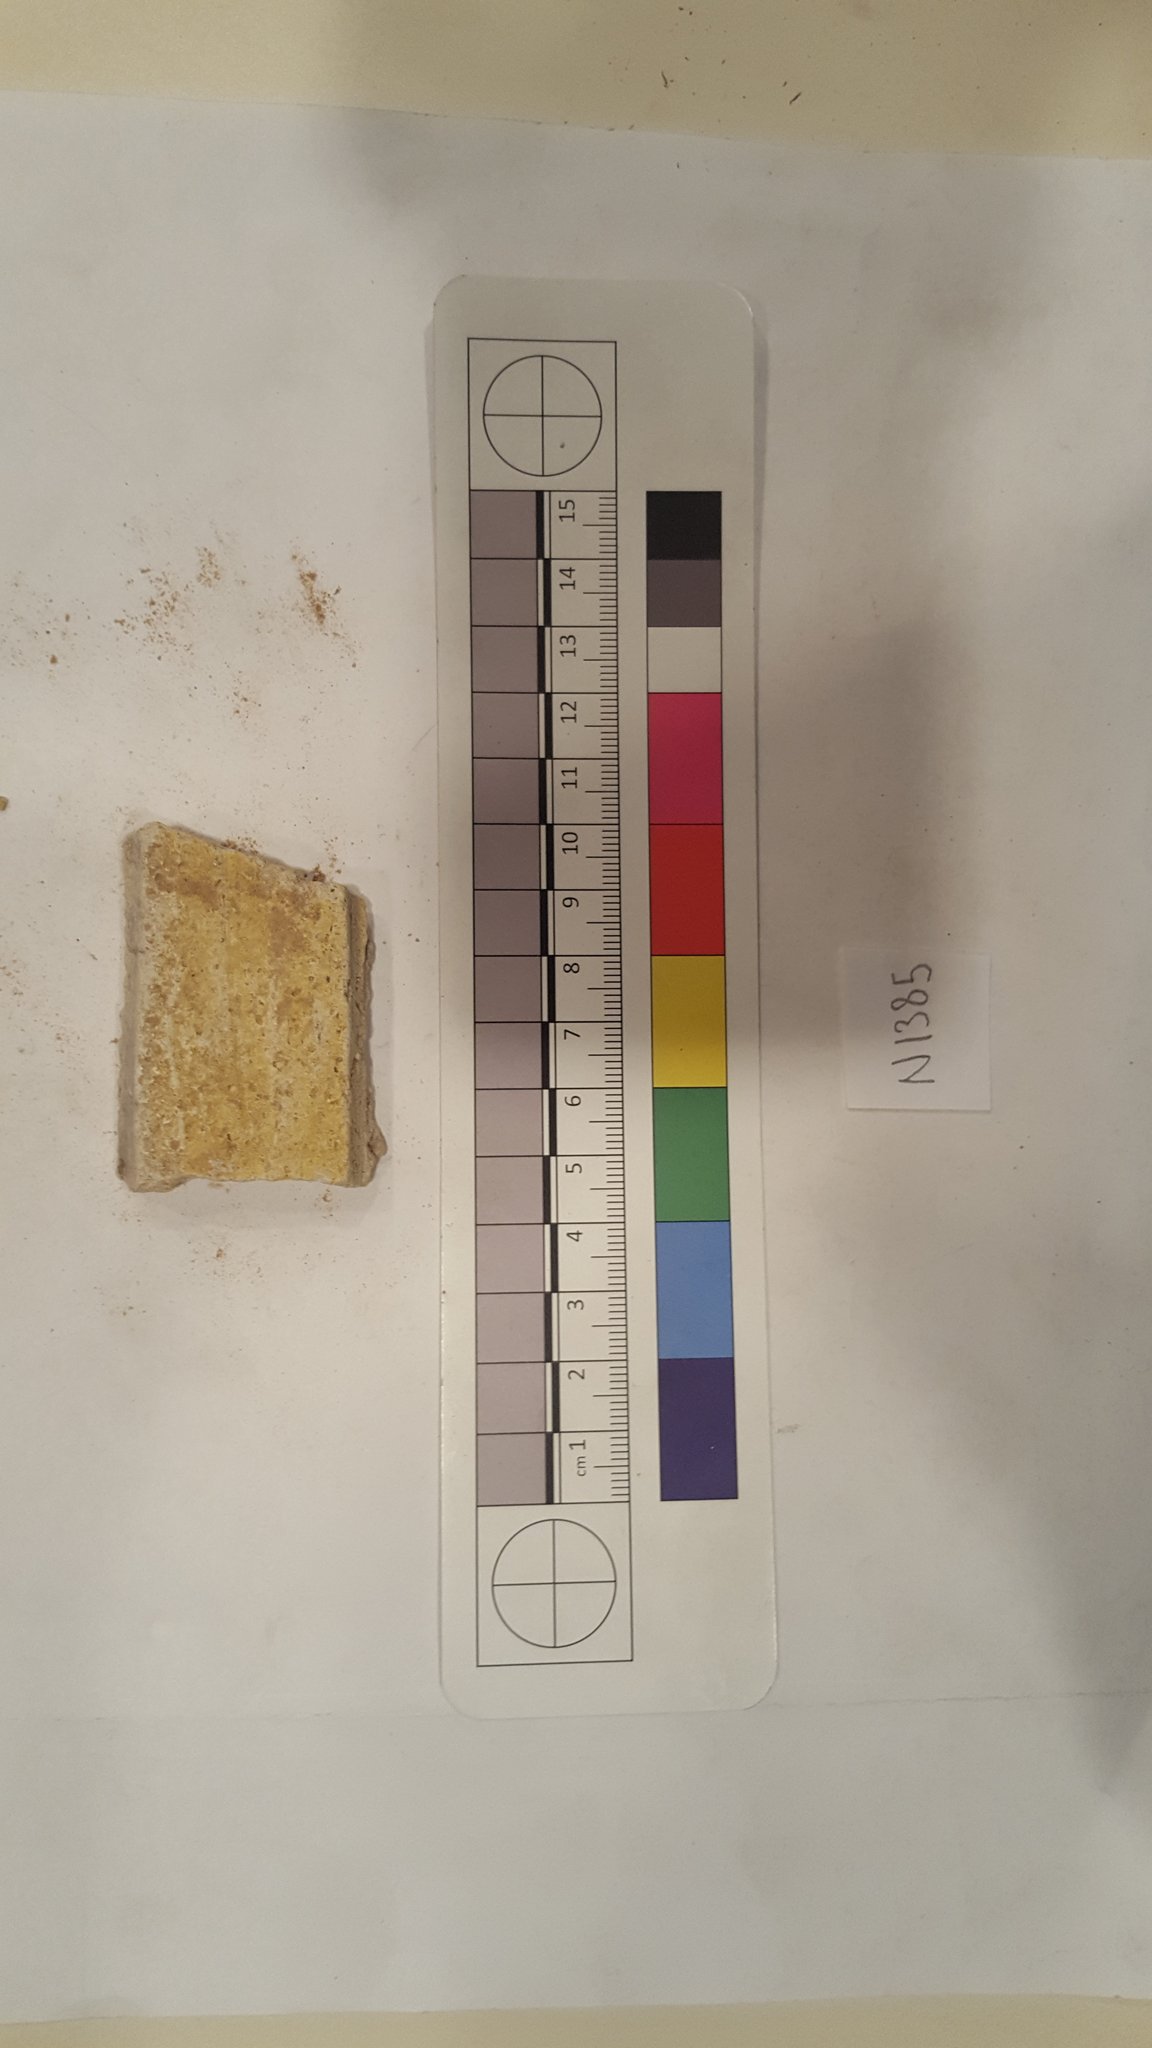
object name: fragment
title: Stucco Fragment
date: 701-1200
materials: plaster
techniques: carving, painting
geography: iran